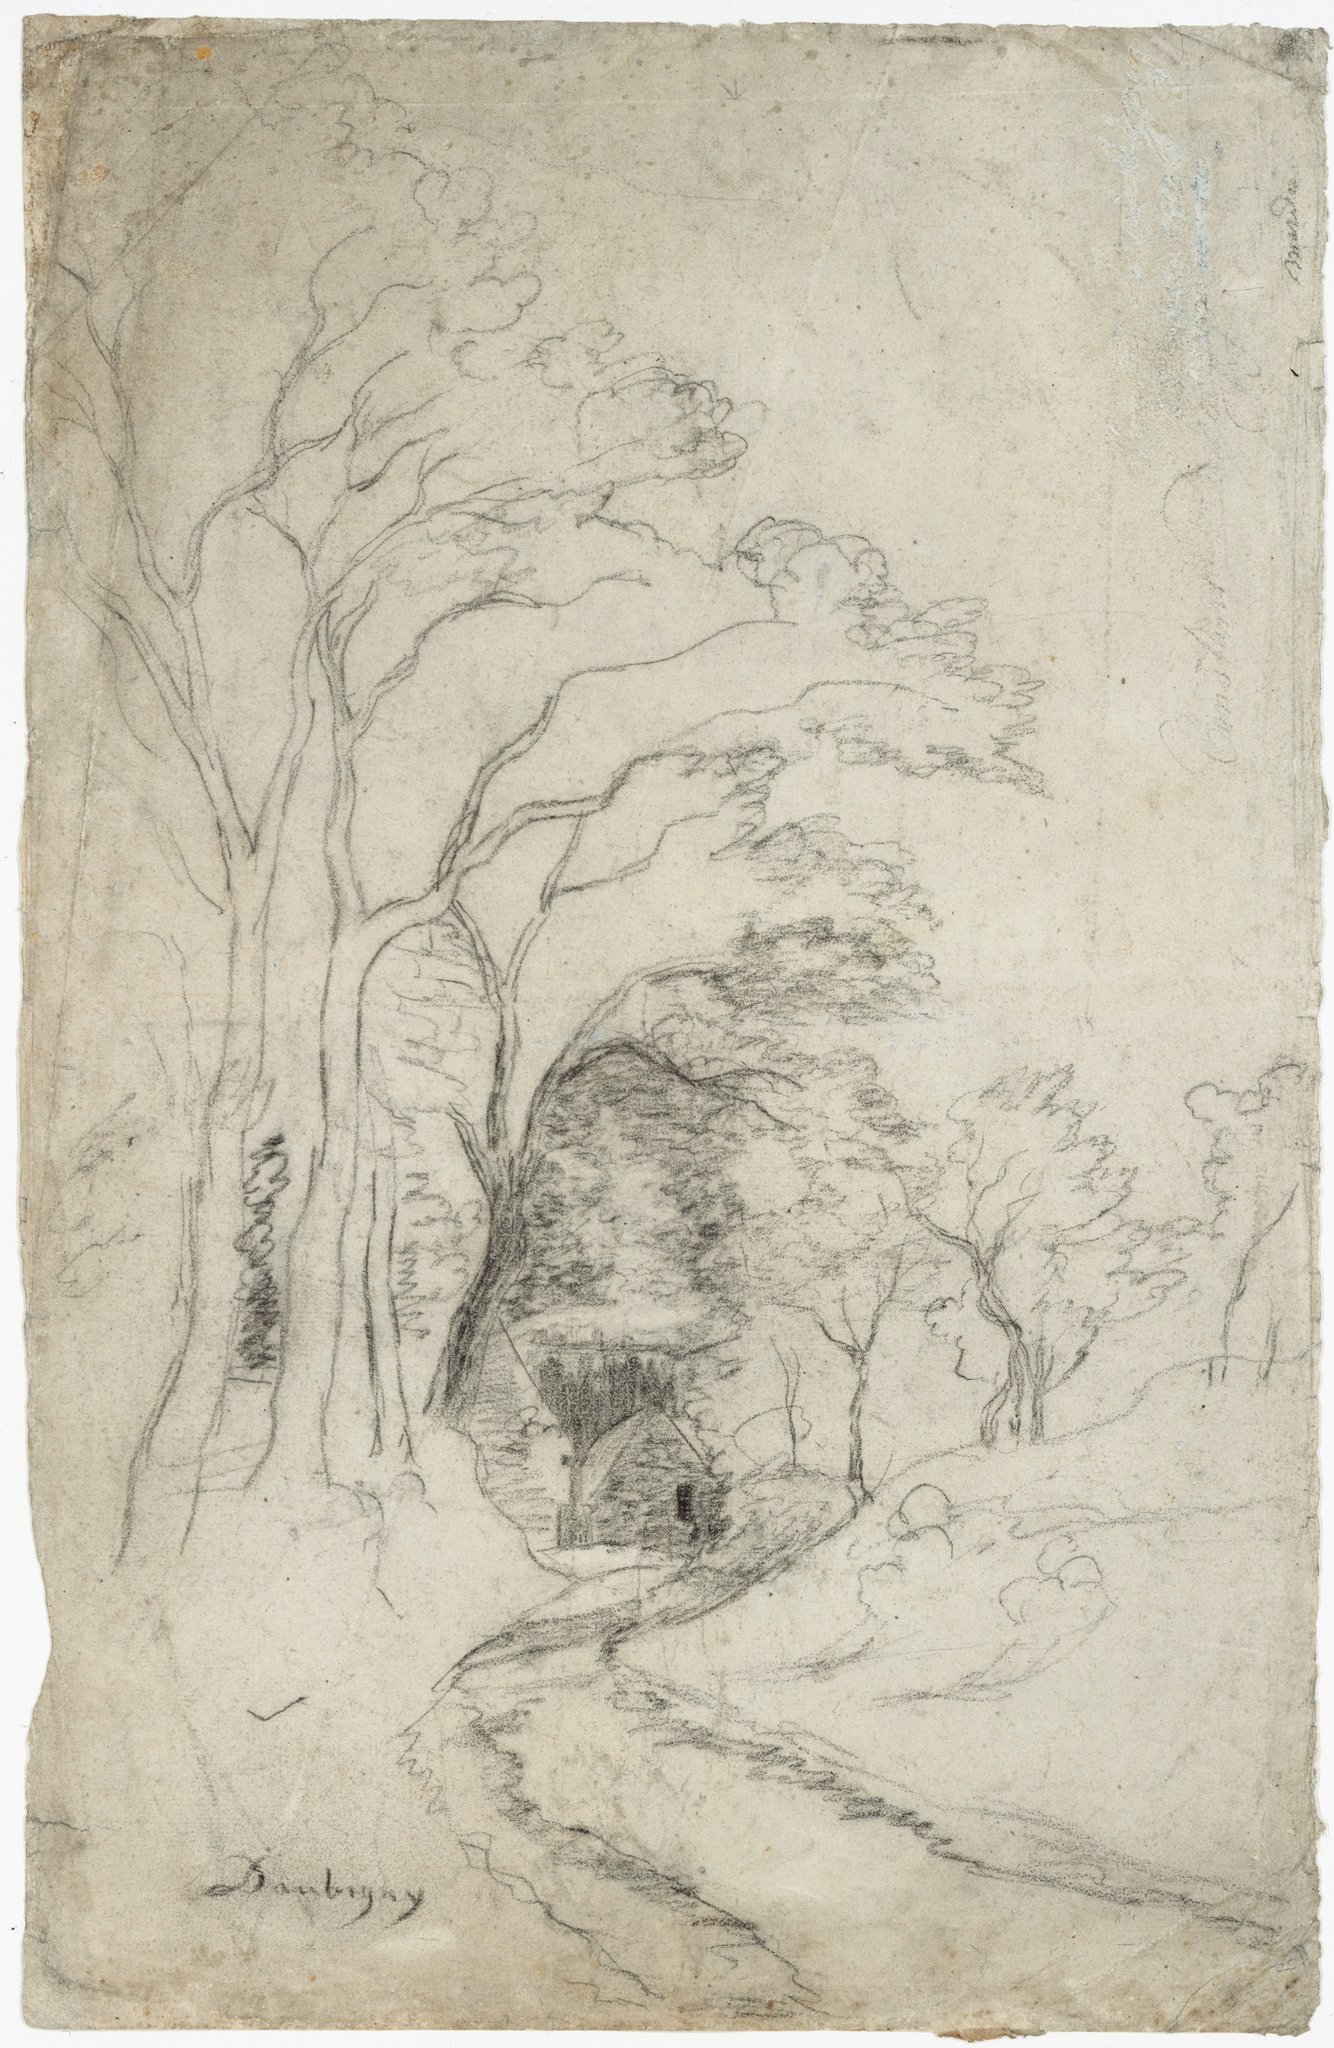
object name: drawing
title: Country Road Landscape with Trees (recto); Landscape with Trees (verso)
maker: charles-françois daubigny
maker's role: artist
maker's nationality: french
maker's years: 1817-1878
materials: chalk, paper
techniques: wash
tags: roads,landscapes